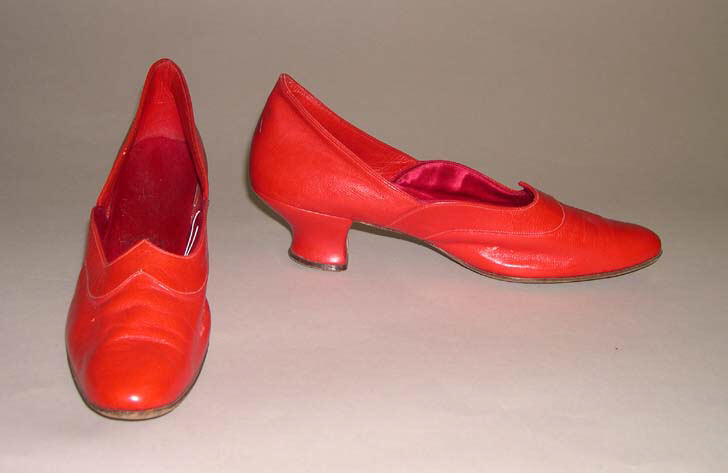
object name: shoe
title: Shoes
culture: british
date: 1880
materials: leather, silk